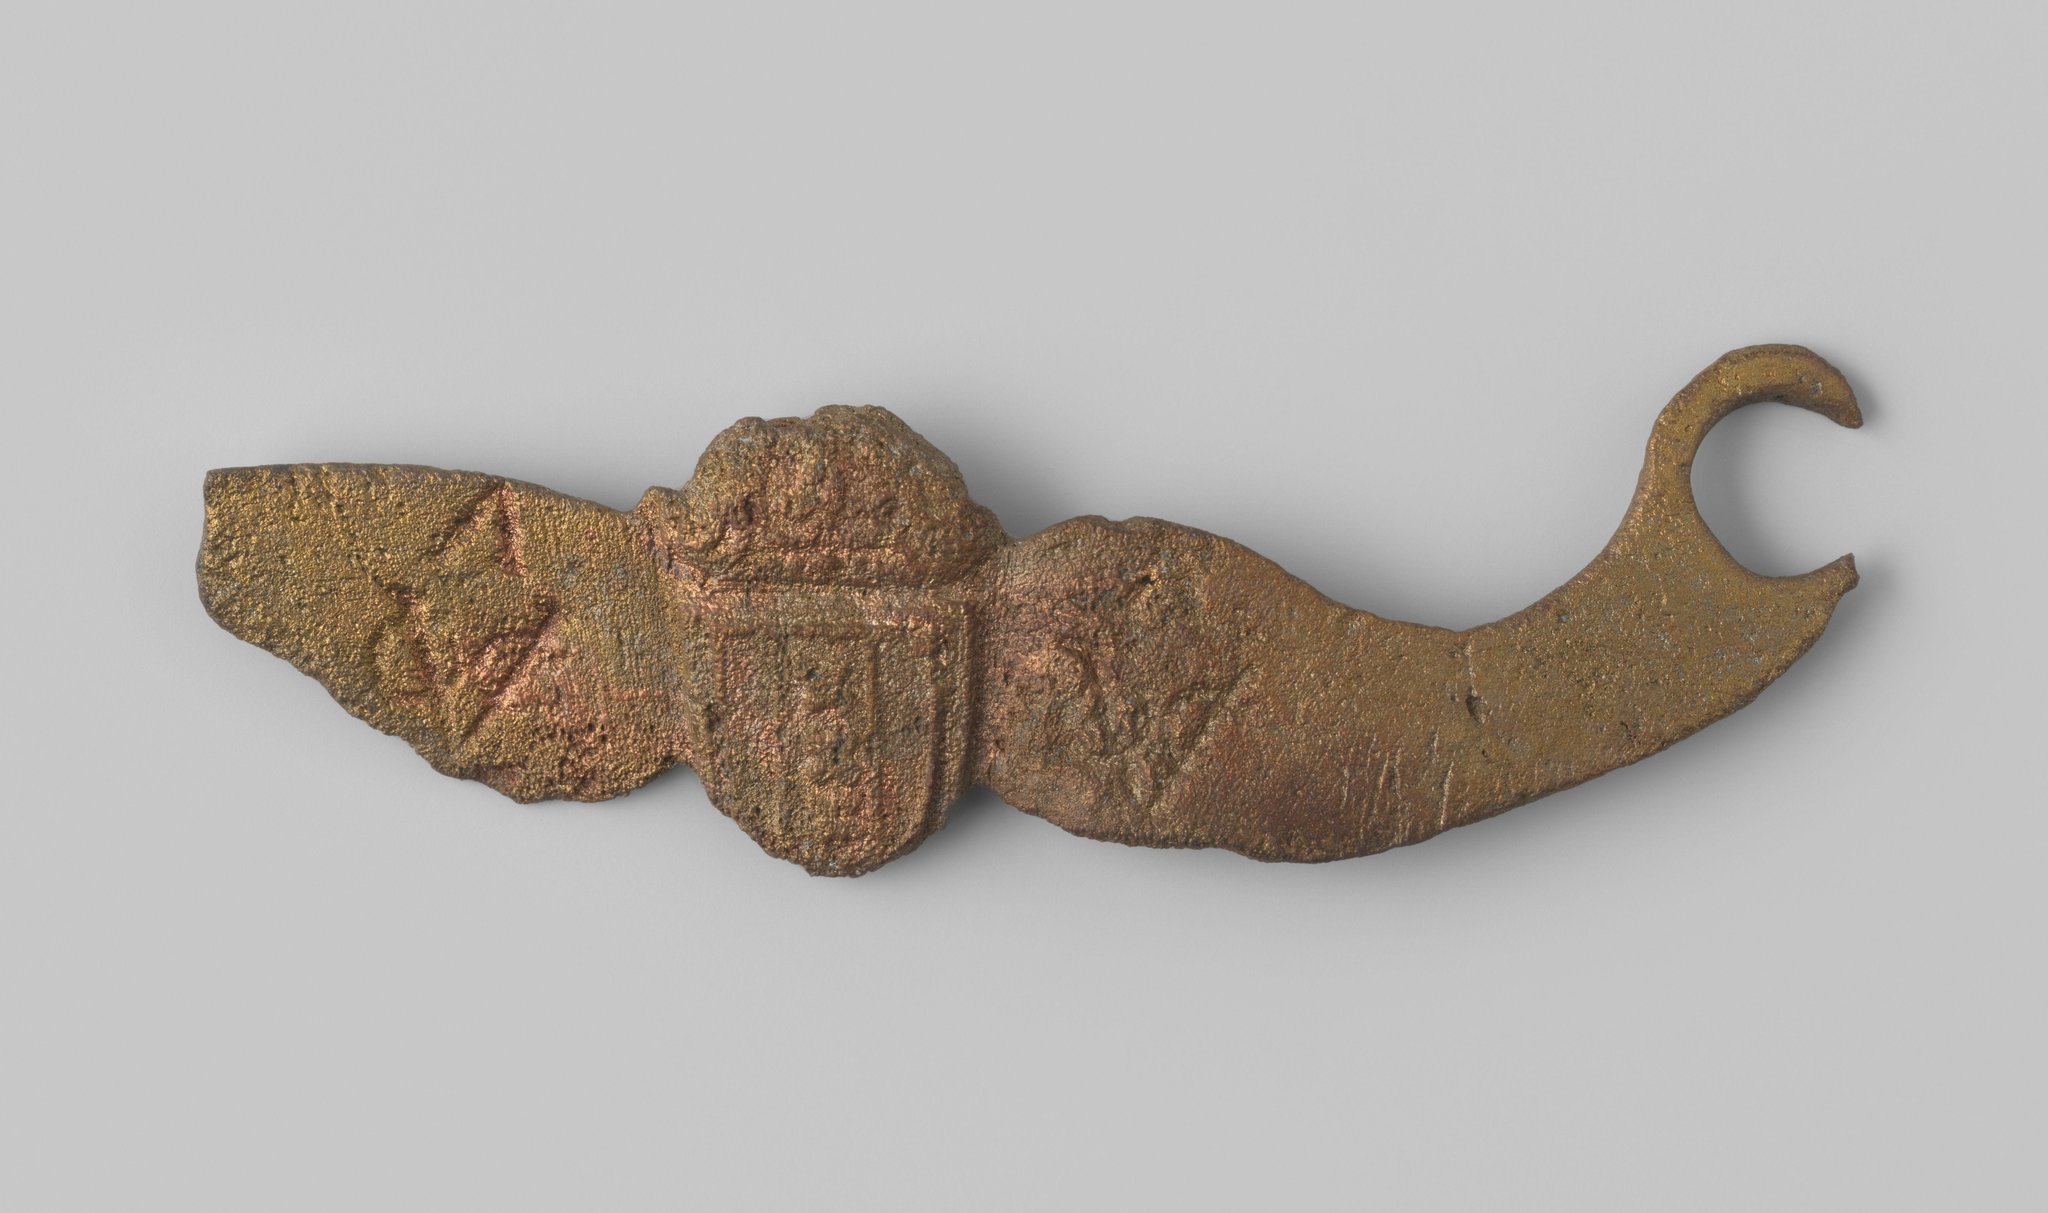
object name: schroefplaat, schroefblik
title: Fragment schroefplaat van een musket uit het wrak van de Oost-Indiëvaarder Hollandia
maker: Anonymous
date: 1700-1743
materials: copper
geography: netherlands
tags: verenigde oostindische compagnie, hollandia (schip), annet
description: Id. NG 1980-27H3069, right eye damaged, side plate.